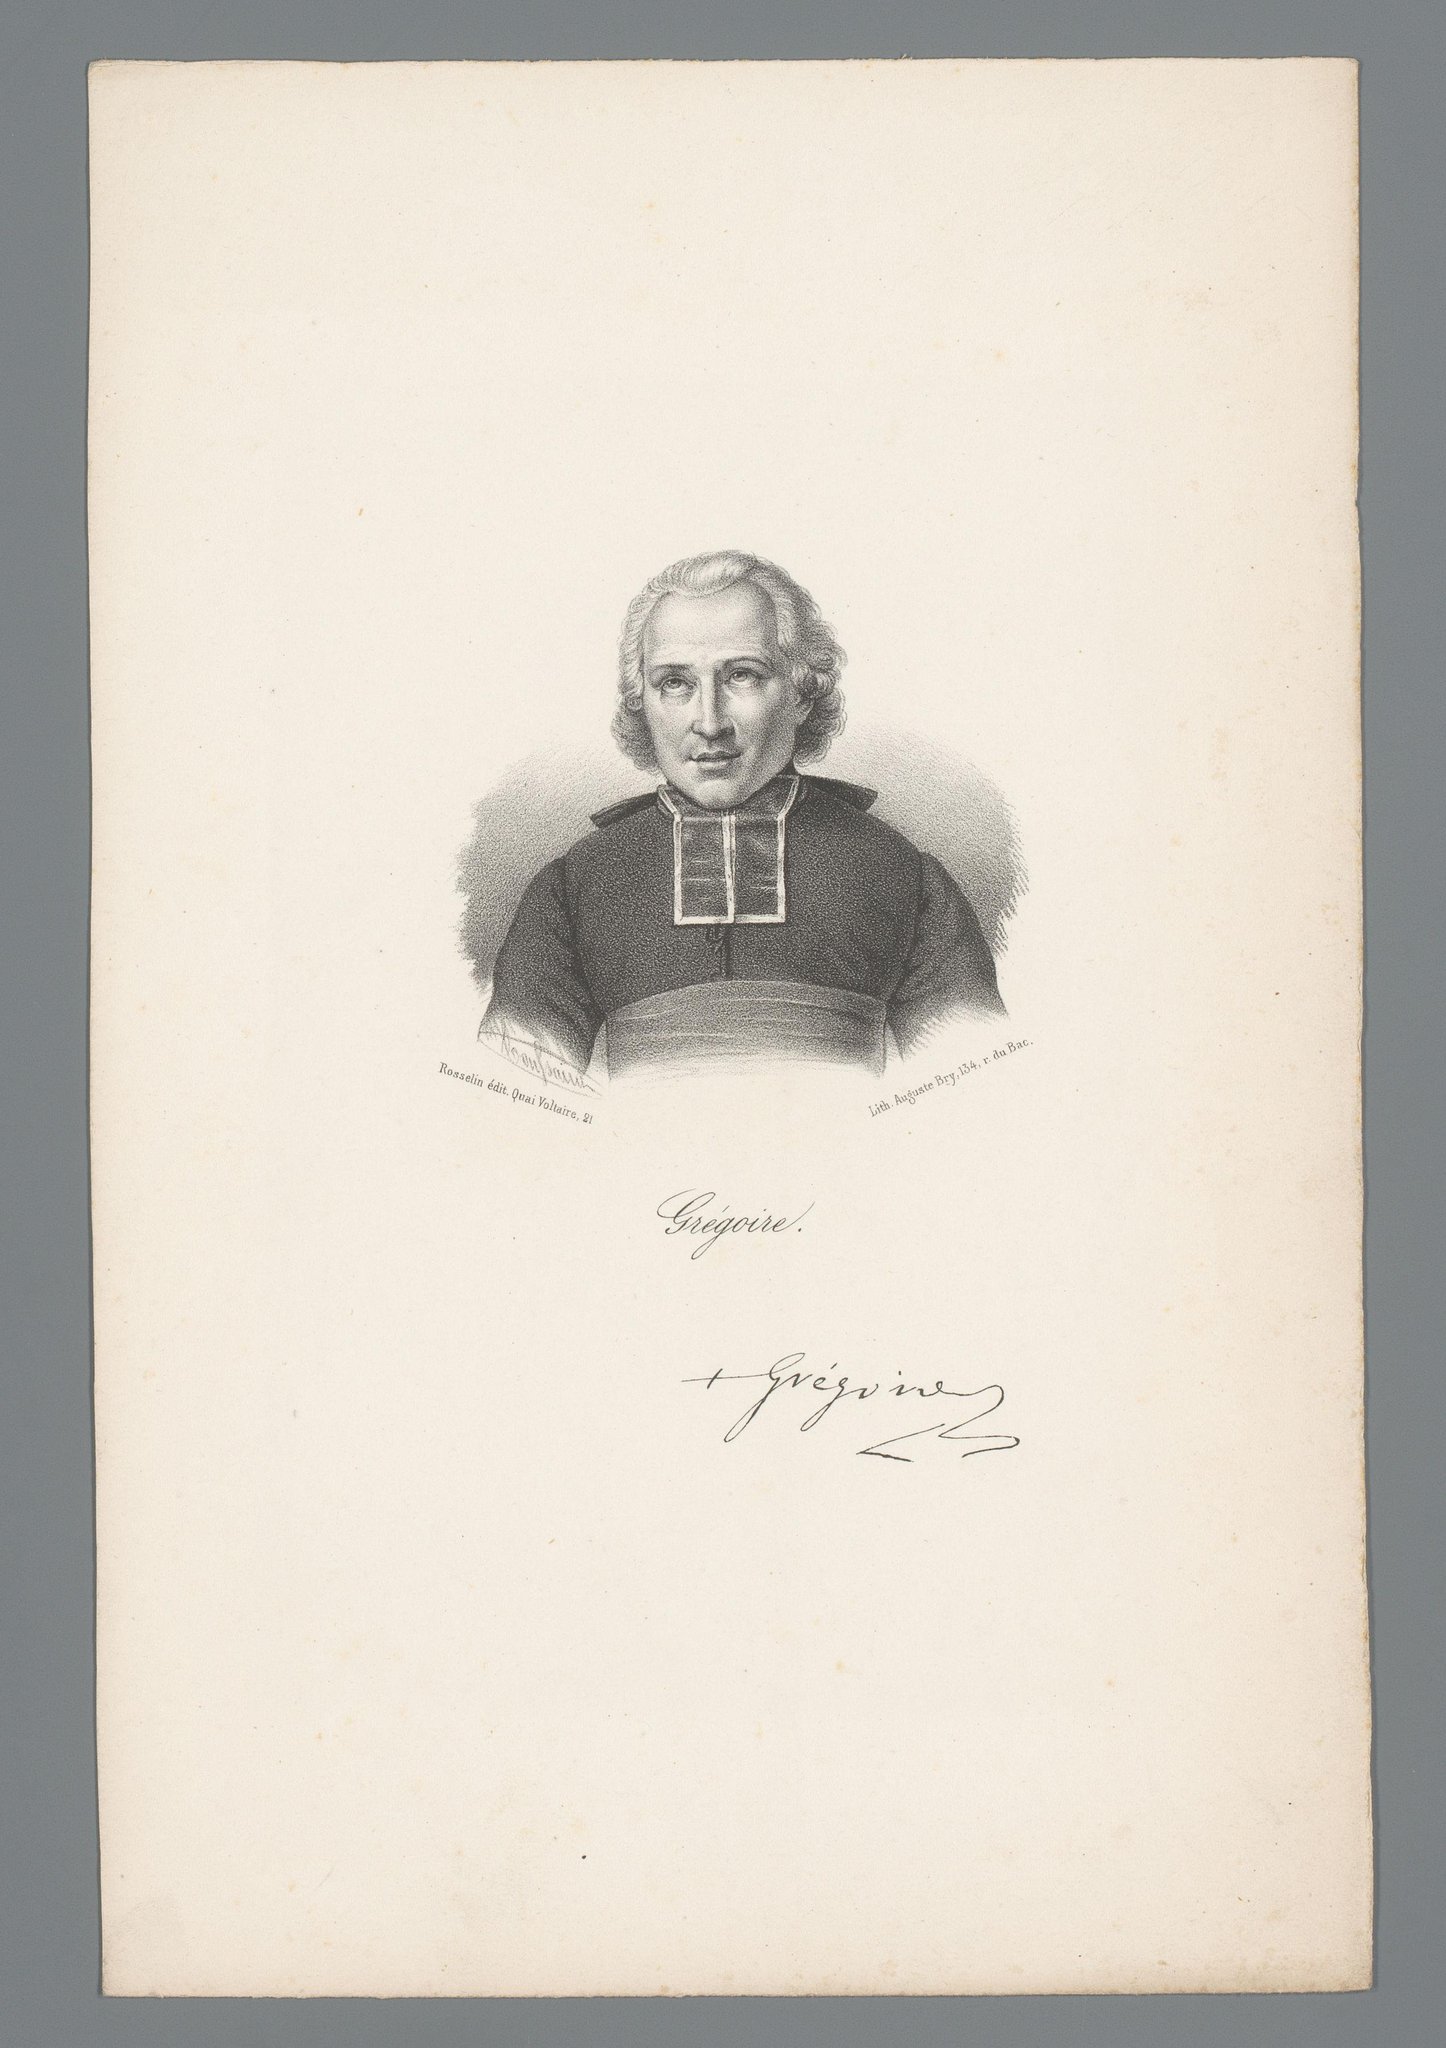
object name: print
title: Portret van Henri Grégoire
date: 1846-1848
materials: paper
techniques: lithograph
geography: paris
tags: priest, historical persons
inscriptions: collector's mark: Lugt 2228